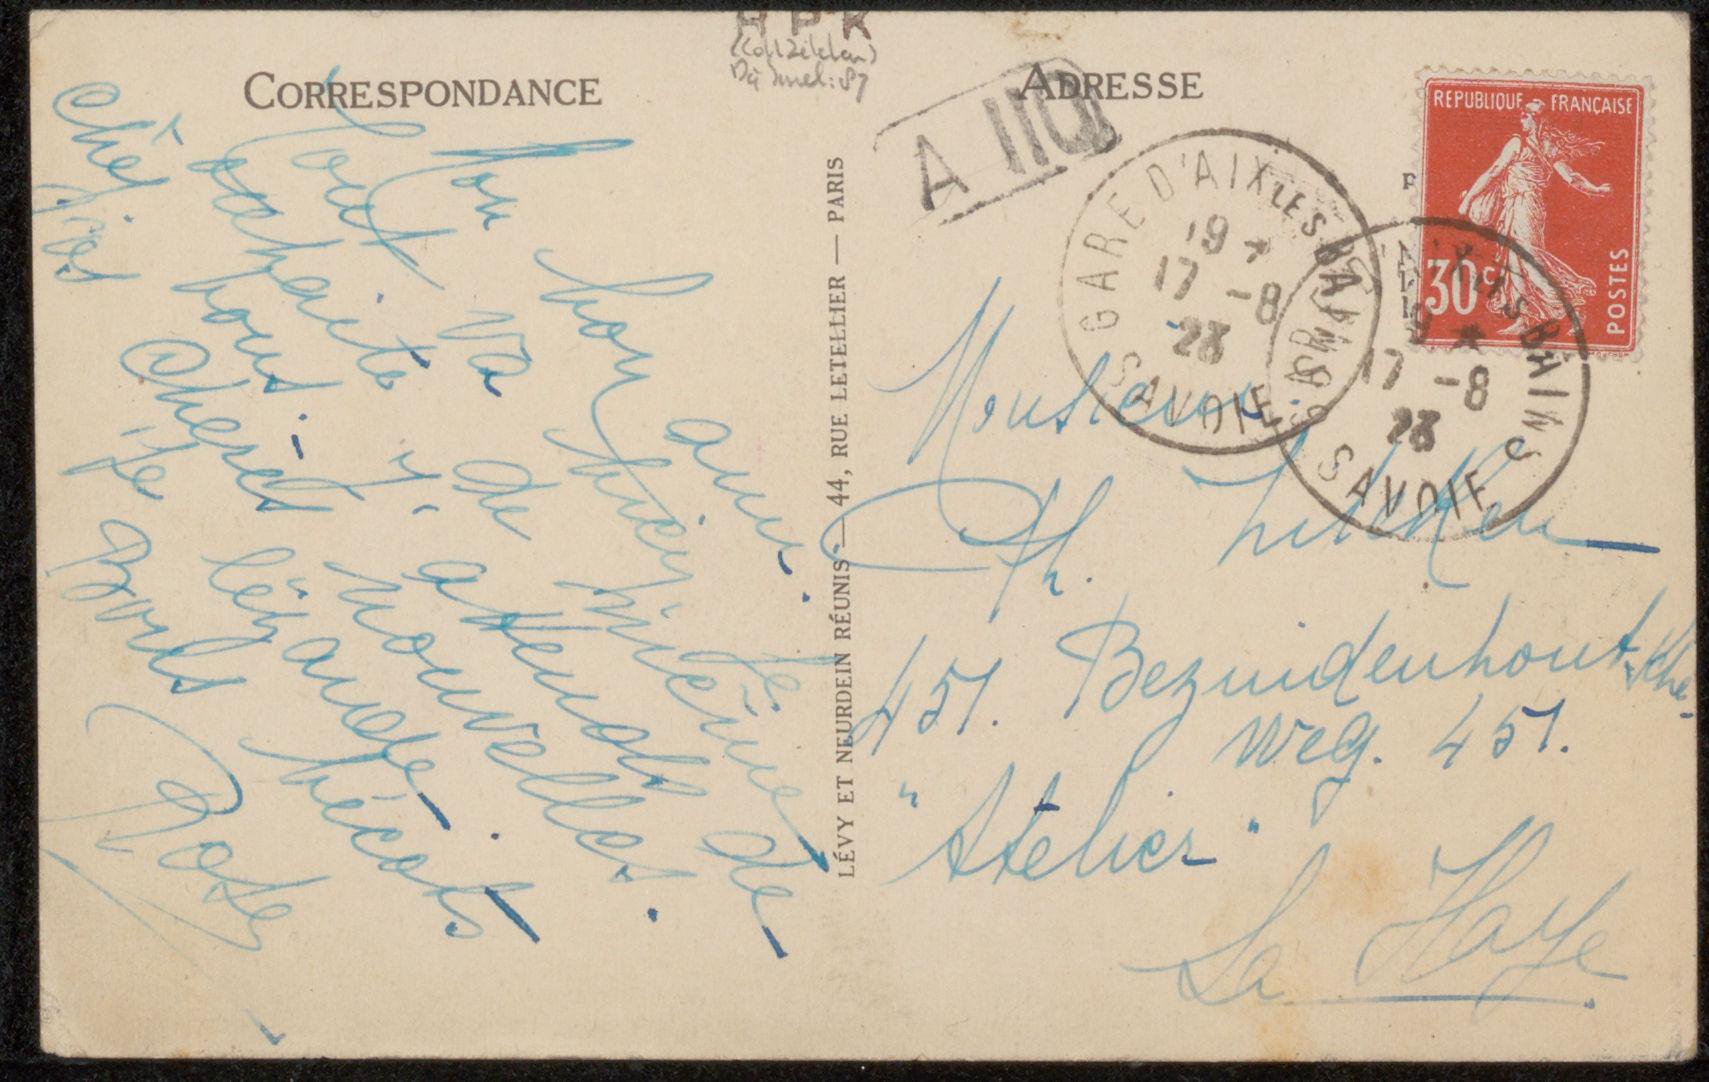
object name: ansichtkaart, prentbriefkaart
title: Prentbriefkaart aan Philip Zilcken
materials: cardboard, ink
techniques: pen, printing, writing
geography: paris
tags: the hague, painter, draughtsman, philip zilcken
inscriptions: collector's mark: ‘RPK’